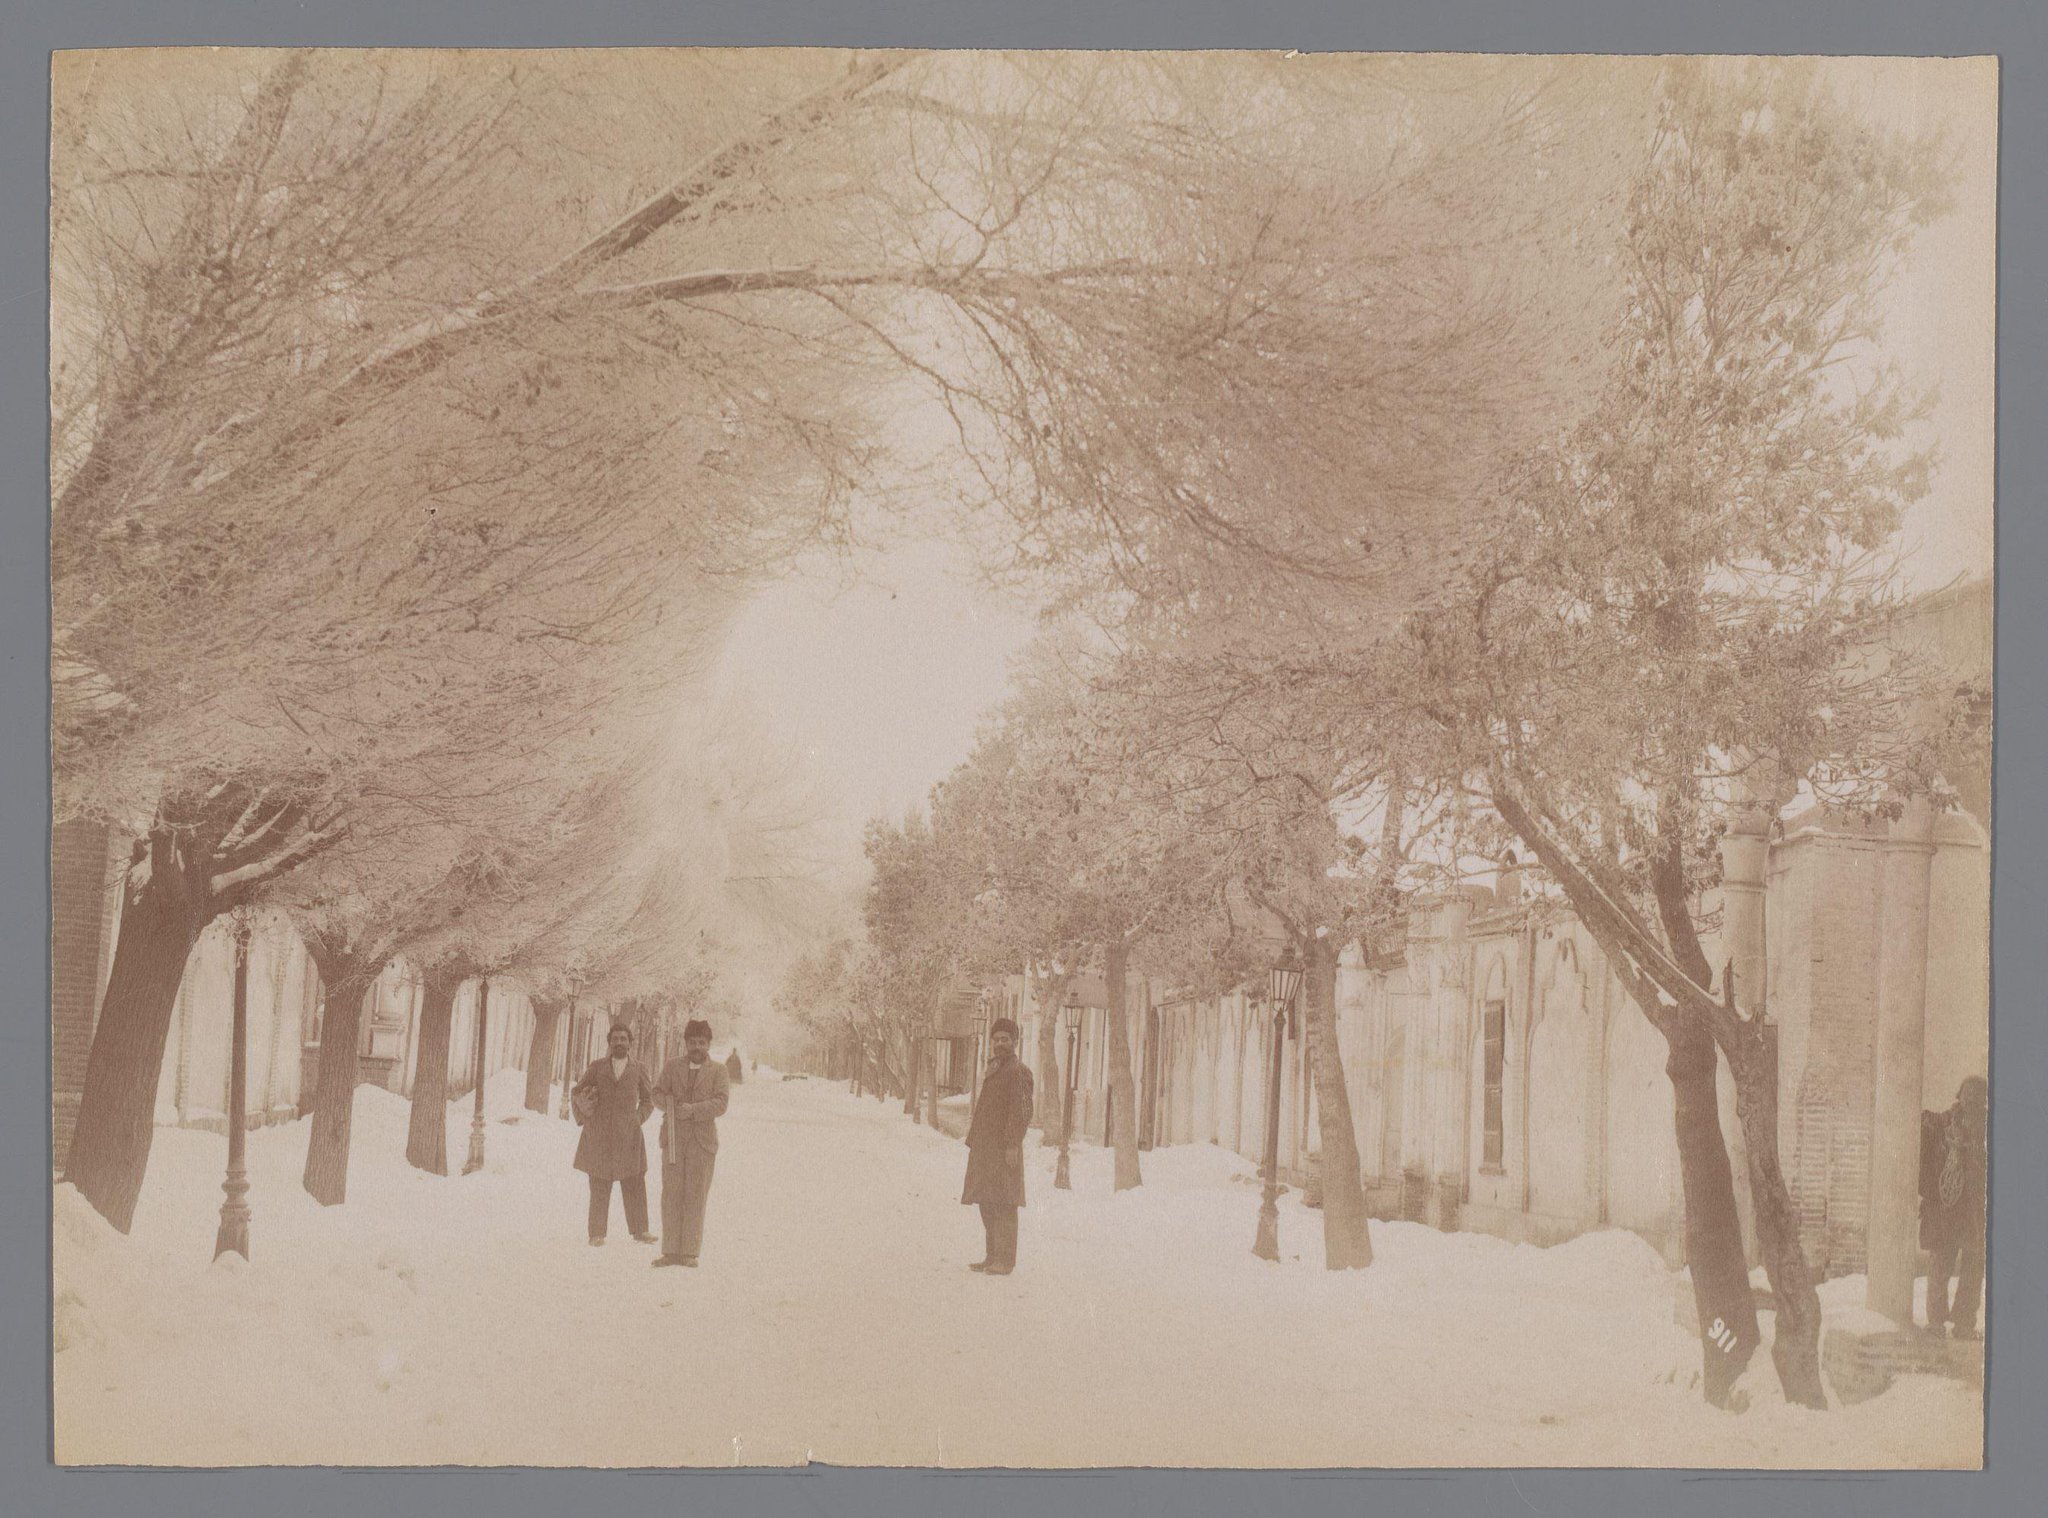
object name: photograph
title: Avenue Aladavleh in de sneeuw, Teheran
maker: antoine sevruguin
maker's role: fotograaf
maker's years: 1840-1933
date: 1885-1910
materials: paper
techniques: albumen print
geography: iran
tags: teheran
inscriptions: number: ‘10.’, inscription: ‘Teheran//Avenue Aladavleh’, number: ‘911’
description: Avenue Aladavleh, Teheran, Iran. Besneeuwde straat en bomen, met drie voor de camera poserende mannen. Een daarvan draagt een geweer [?].